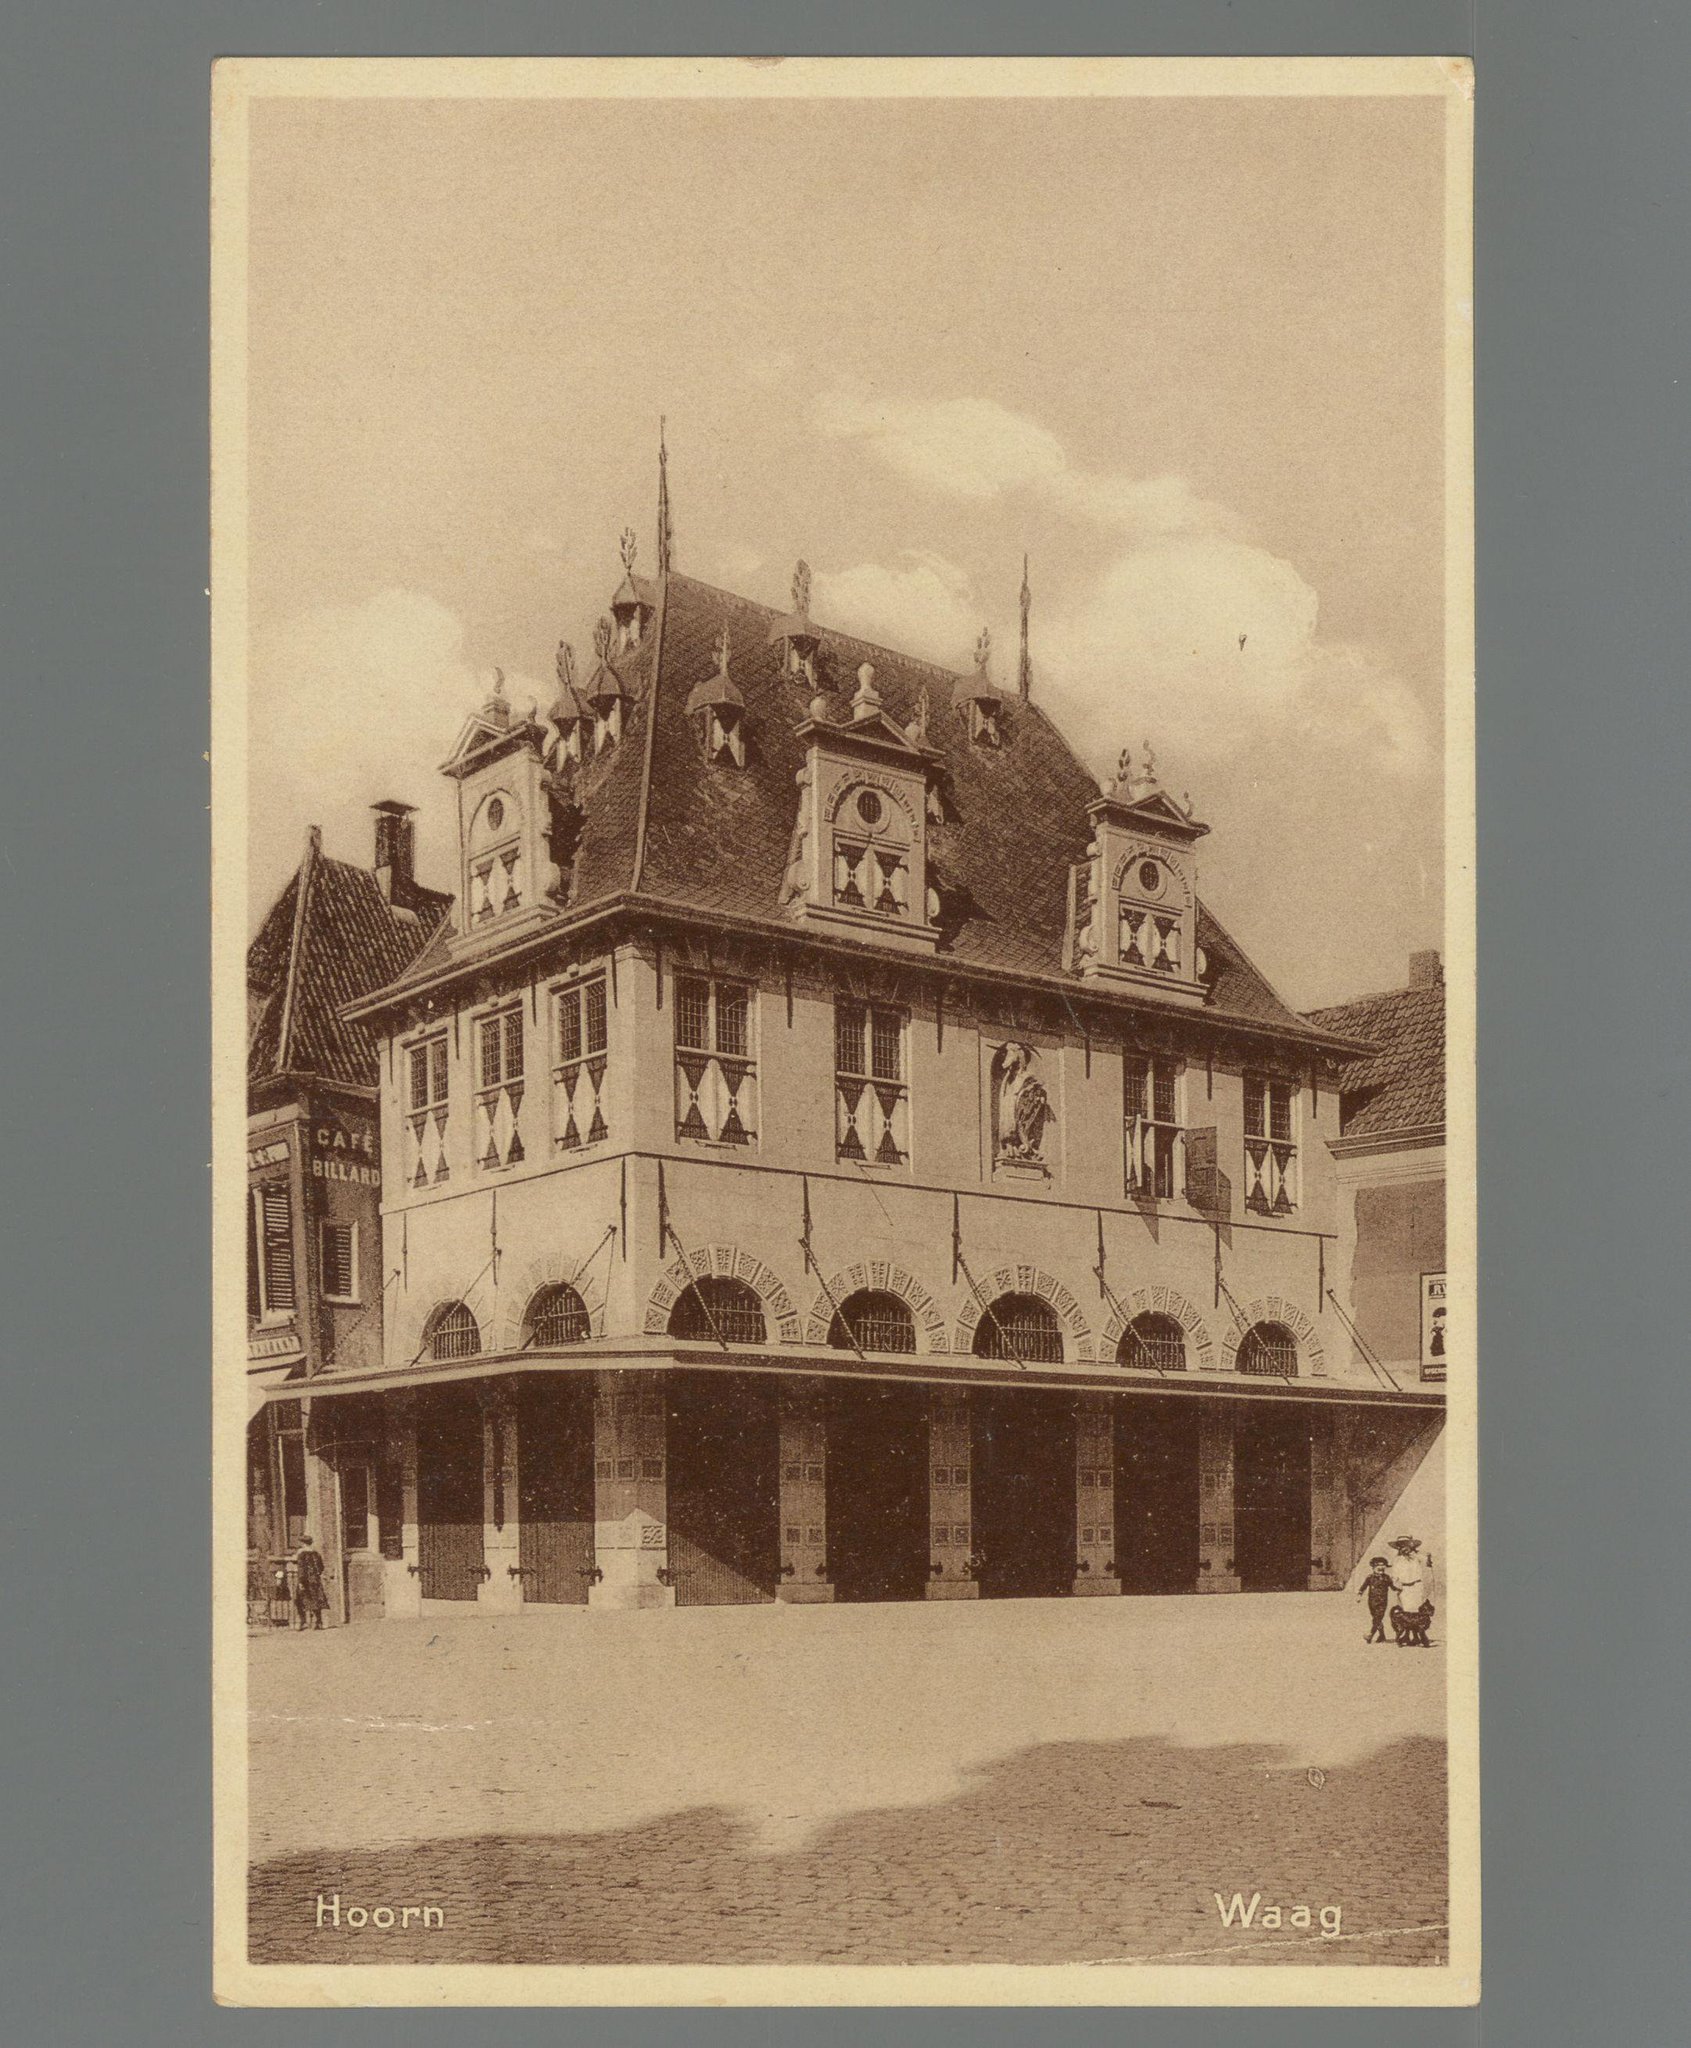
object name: ansichtkaart, prentbriefkaart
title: Hoorn Waag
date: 1926-1935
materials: cardboard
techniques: photograph, writing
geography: hoorn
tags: city-view, and landscape with man-made constructions, (architectural) structures connected with law and justice, hoorn (north holland)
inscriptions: postage stamp